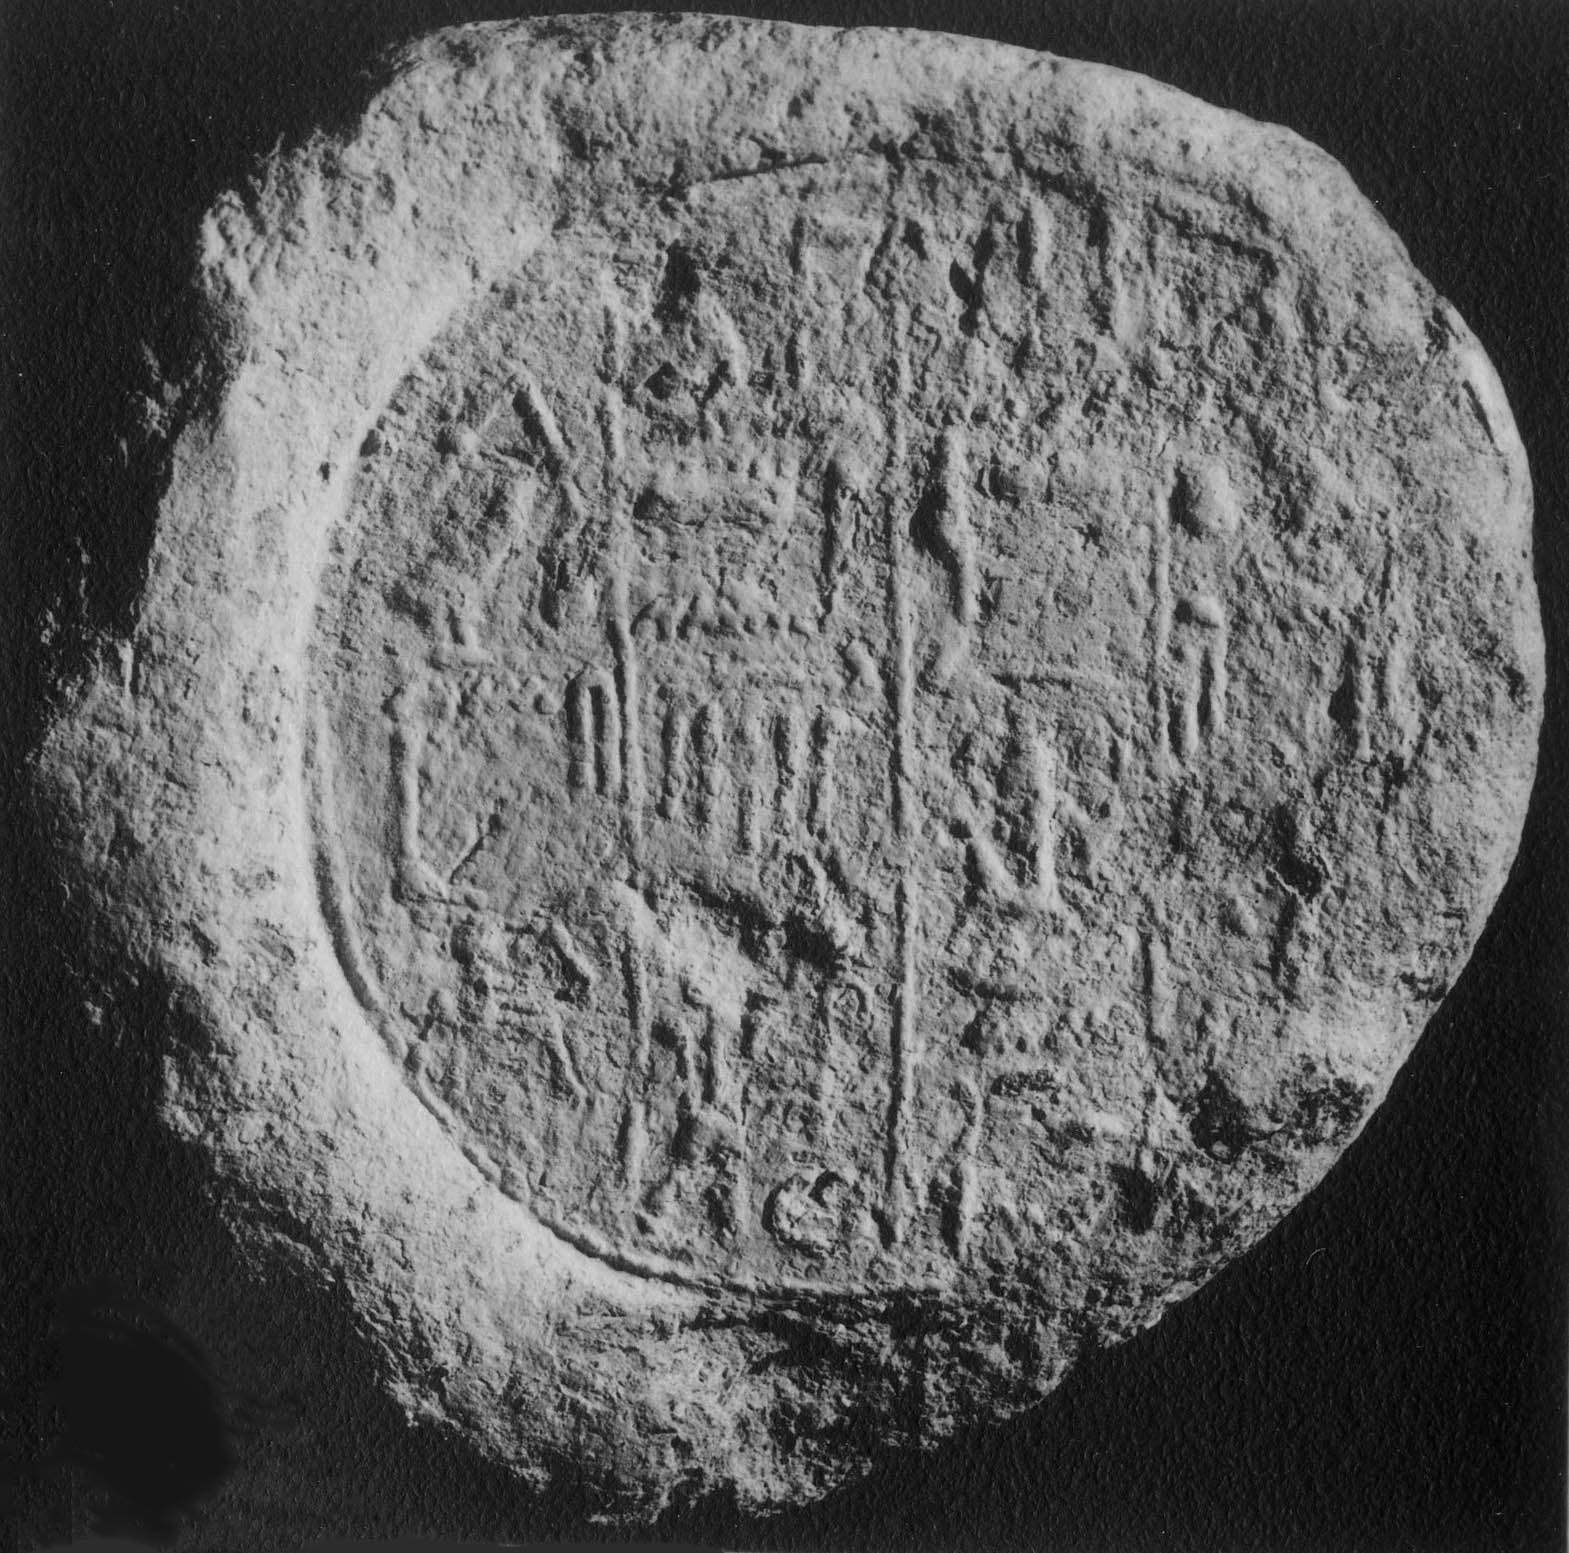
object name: cone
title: Funerary Cone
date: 1550-1295 BCE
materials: pottery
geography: egypt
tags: hieroglyphs